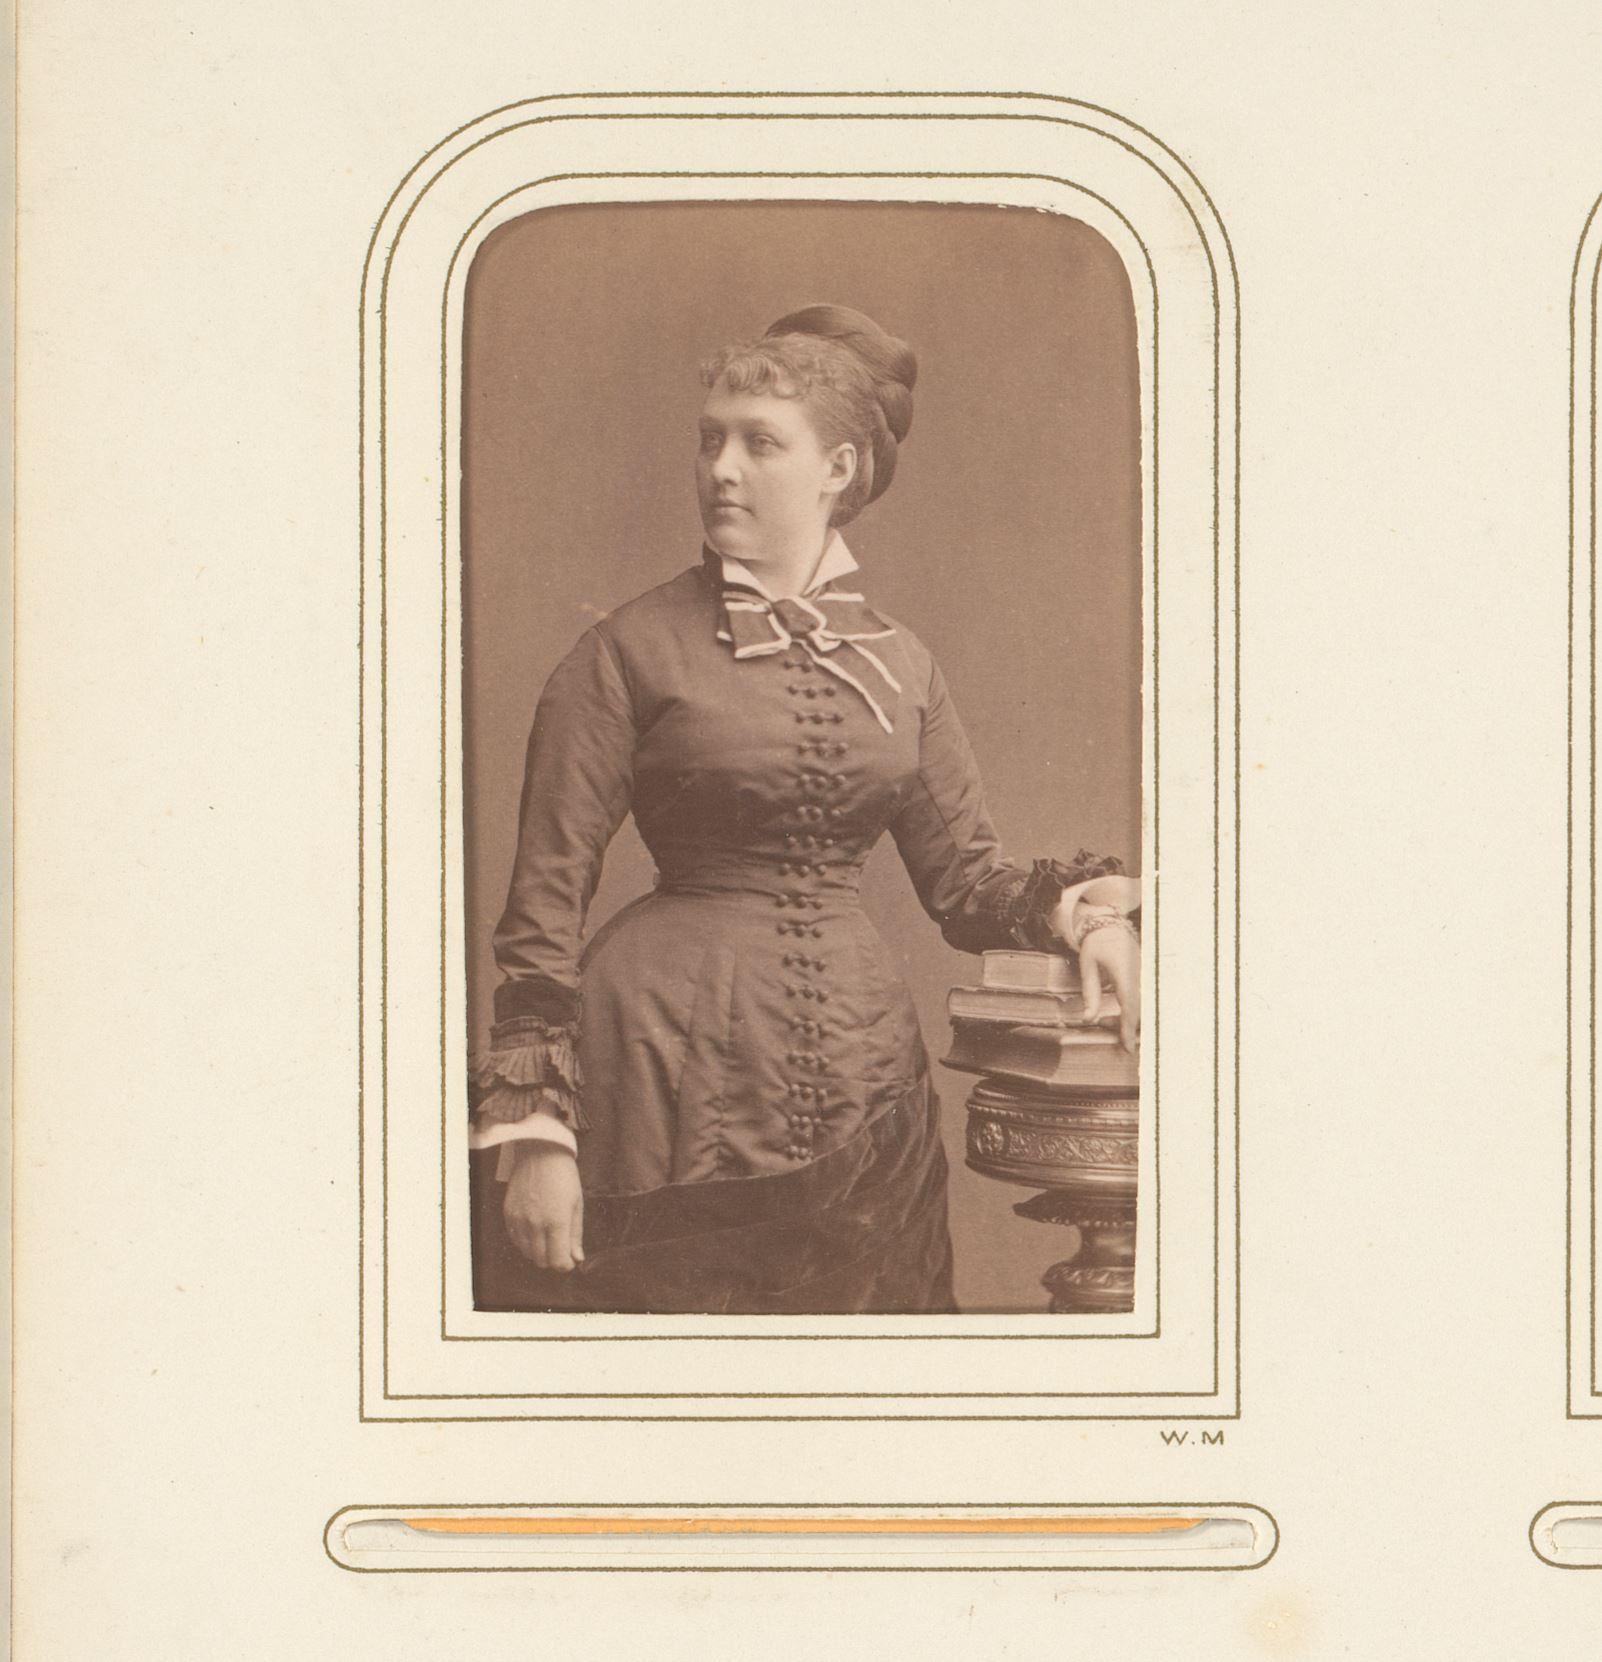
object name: carte de visite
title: Portret van Louise Pyk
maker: gösta florman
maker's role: fotograaf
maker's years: 1831-1900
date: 1865-1885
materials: cardboard, photographic support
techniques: albumen print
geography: stockholm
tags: historical persons - bb - woman, portrait of opera-singer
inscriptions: annotation: ‘Fröken Pyk’, inscription: ‘Gösta Florman/ STOCKHOLM/ 28A Regeringsgatan 28 A.’